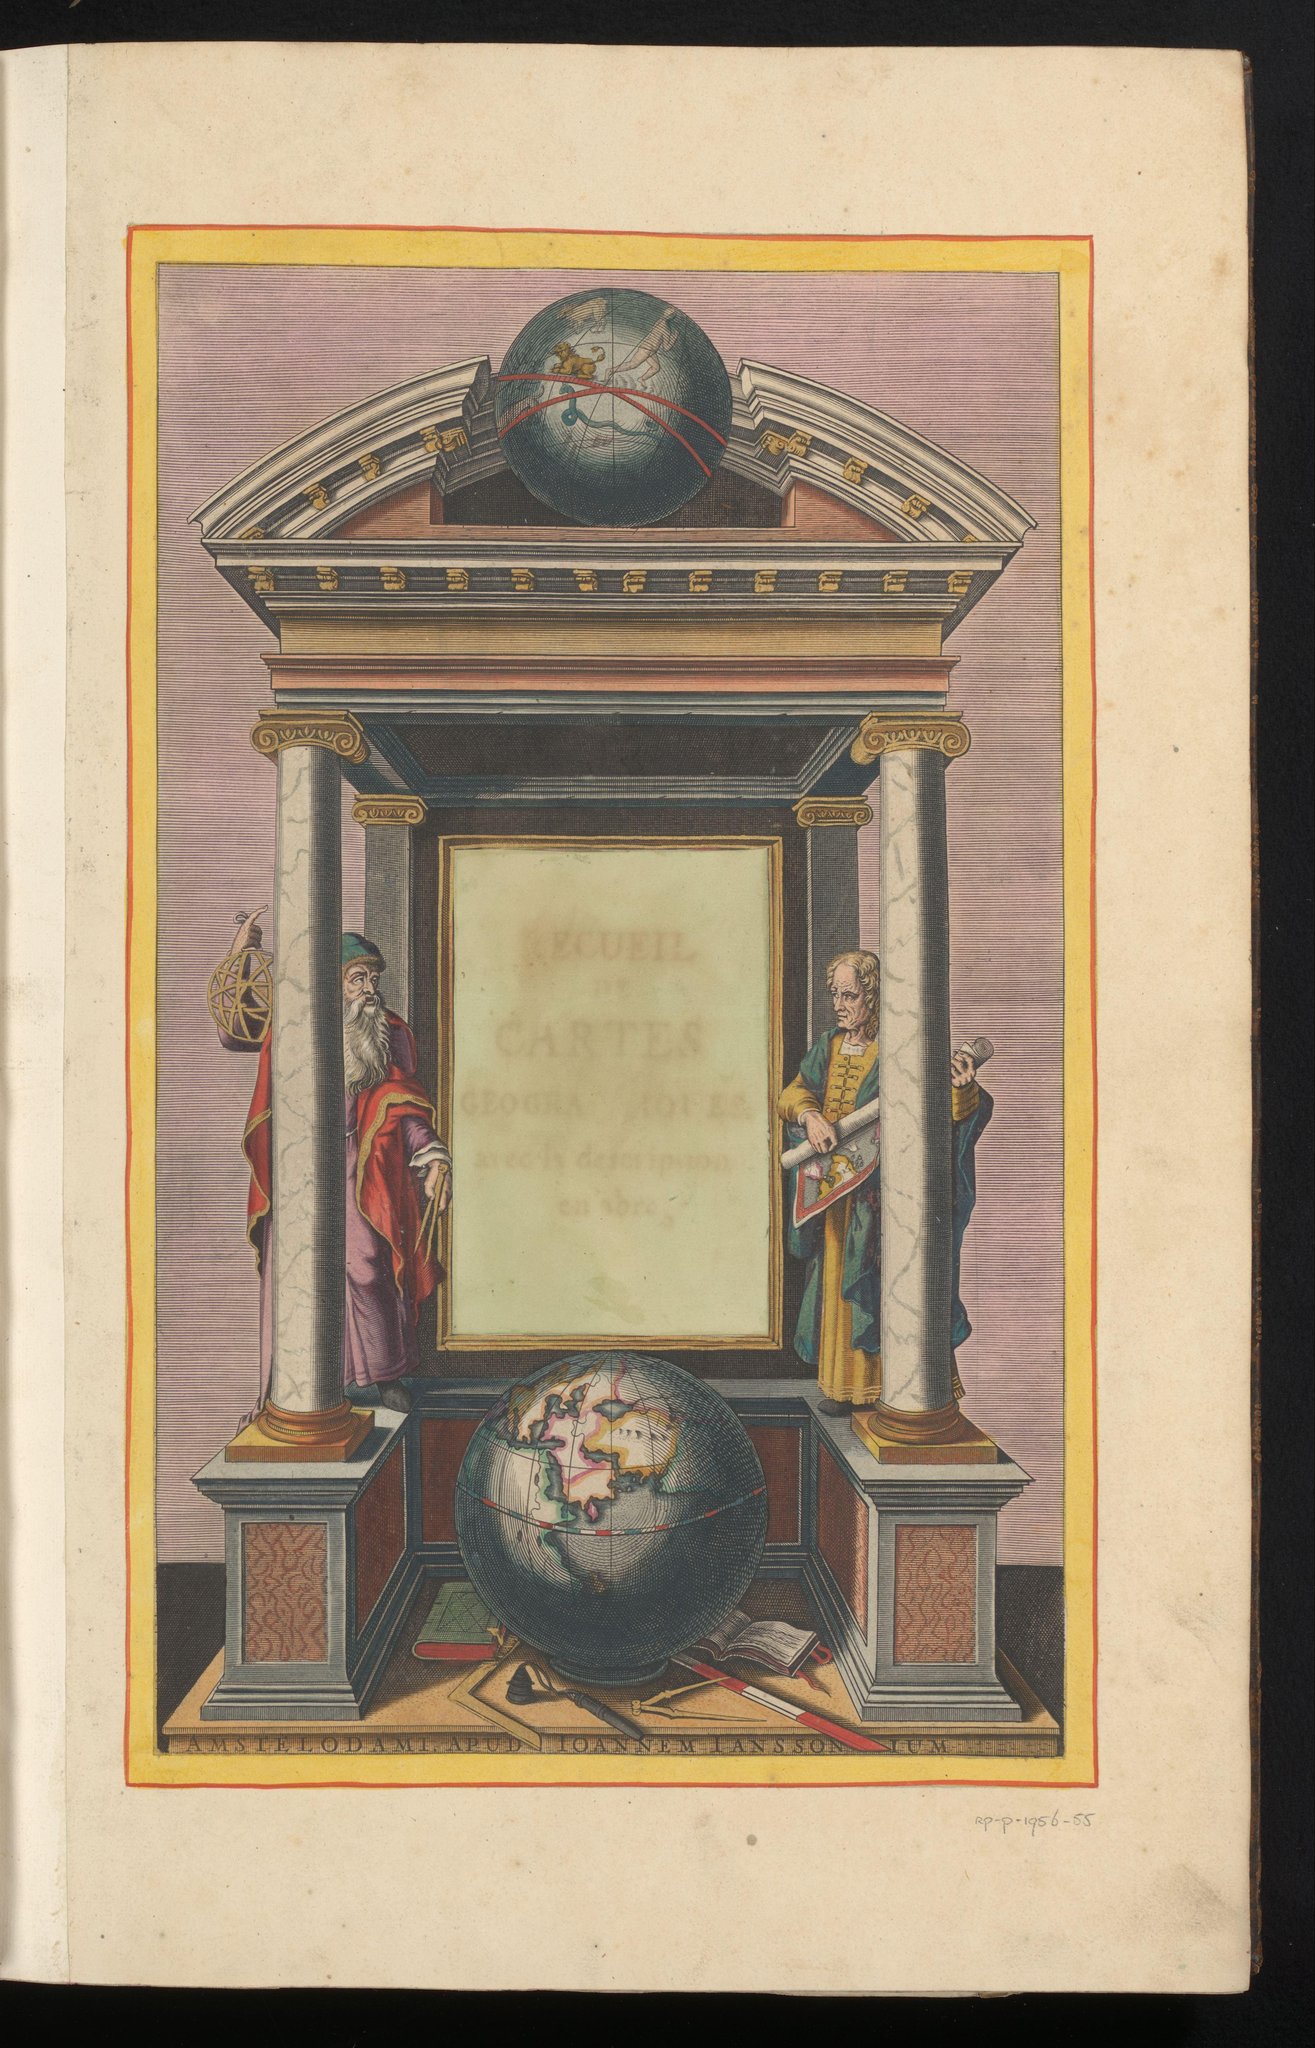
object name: titelprent, frontispice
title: Titelprent met links Ptolemaeus en rechts Marinus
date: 1644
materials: paper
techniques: engraving, hand coloring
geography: the hague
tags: maps, atlases, title-page, globe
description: Titelprent voor een factice atlas, de originele titel overgeplakt met een stuk papier. Factice album, dat wil zeggen: een door een opdrachtgever, verzamelaar of eigenaar van de prenten samengesteld album. Deze prent maakt deel uit van een album.